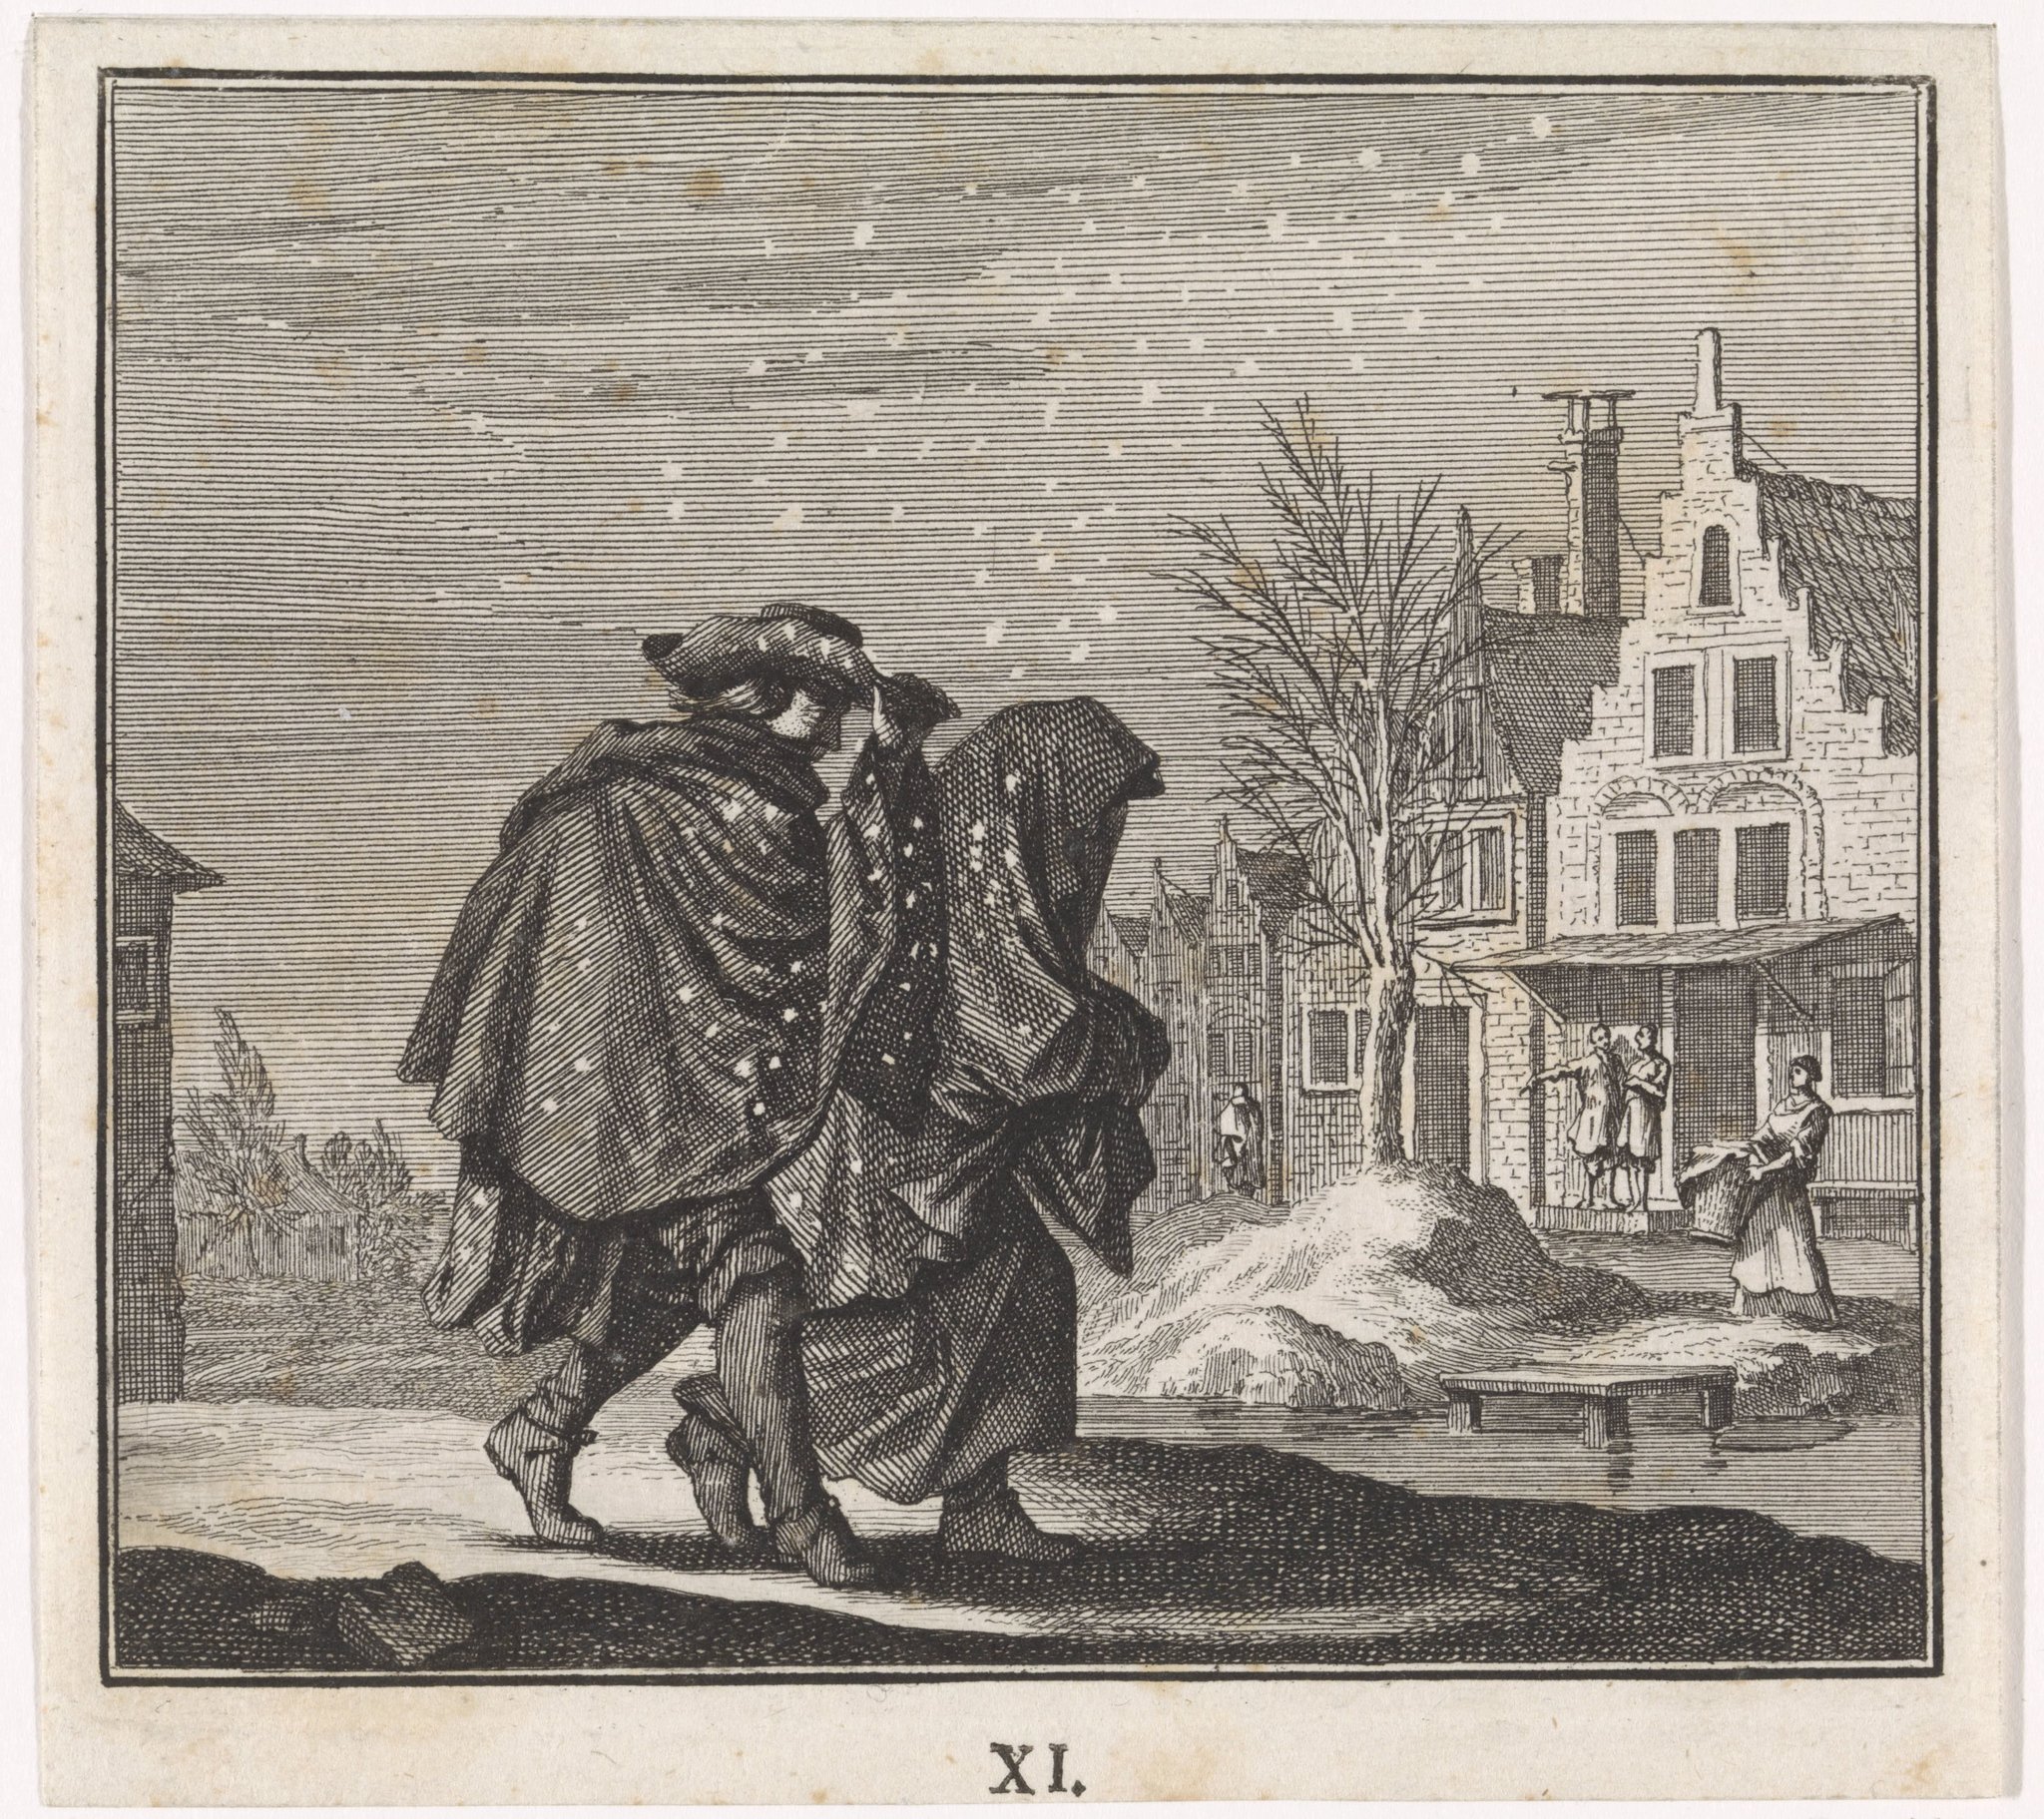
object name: book illustration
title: Reizigers in de sneeuw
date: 1700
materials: paper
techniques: etching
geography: nuremberg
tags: landscapes, canal, snow, snowstorm, 'en route', traveller under way, abstract ideas and concepts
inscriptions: collector's mark: Lugt 2228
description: Boekillustratie voor Weigel, Christoph. Ethica Naturalis seu Documenta Moralia e Variis rerum Naturalium proprietatibus Virtutum Vitiorumq symbolicis imaginibus collecta. Neurenberg: Christoph Weigel: c. 1700.